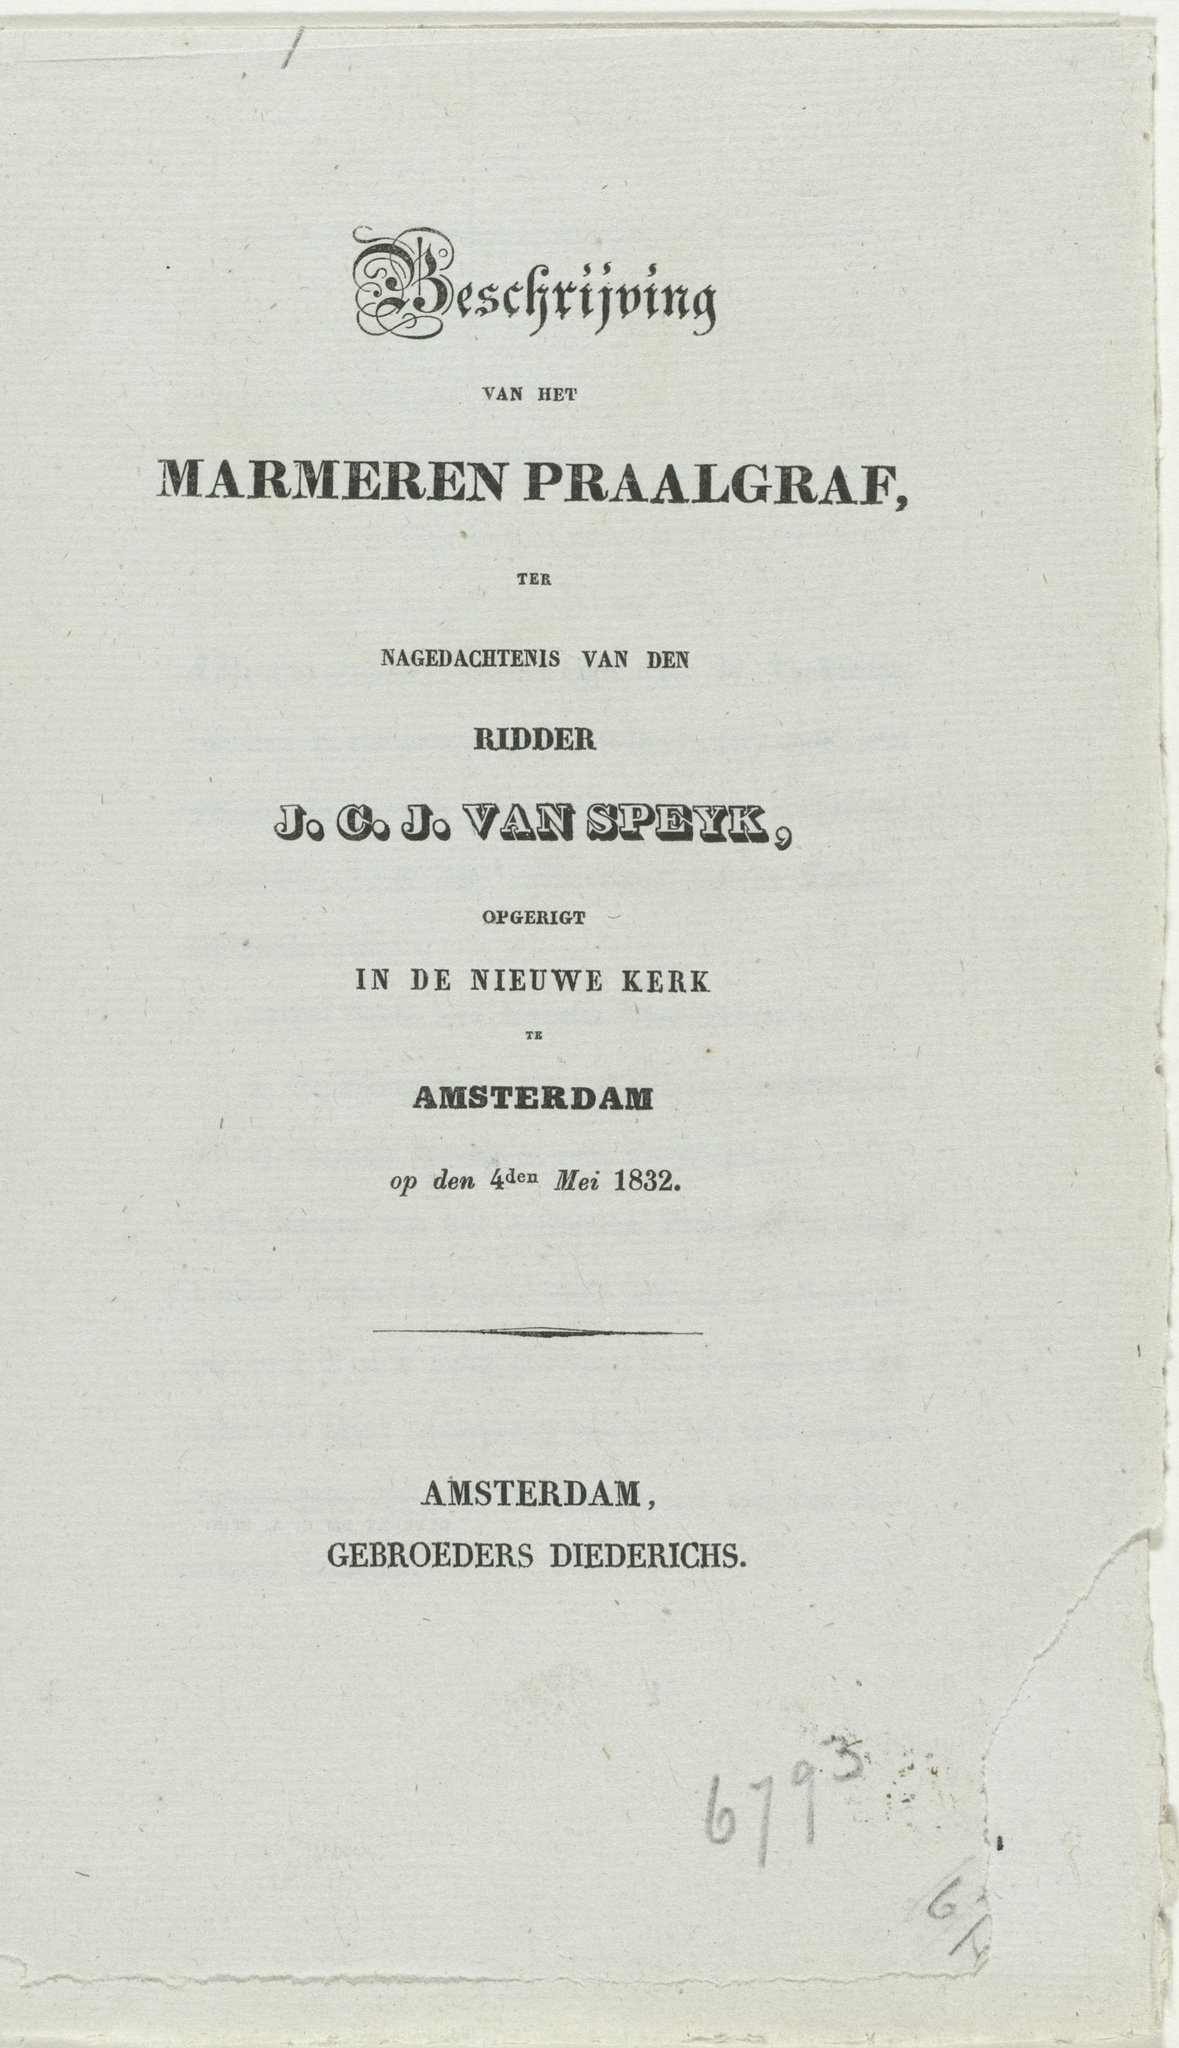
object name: text sheet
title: Beschrijving van praalgraf van Jan van Speyk in de Nieuwe Kerk te Amsterdam, 1832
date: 1832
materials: paper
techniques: letterpress printing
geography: amsterdam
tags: antwerp, jan van speyk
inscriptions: collector's mark: Lugt 2228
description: Gedrukte beschrijving van het praalgraf van Jan van Speyk, opgericht in de Nieuwe Kerk te Amsterdam op 4 mei 1832. Boekje met acht genummerde bladzijden.